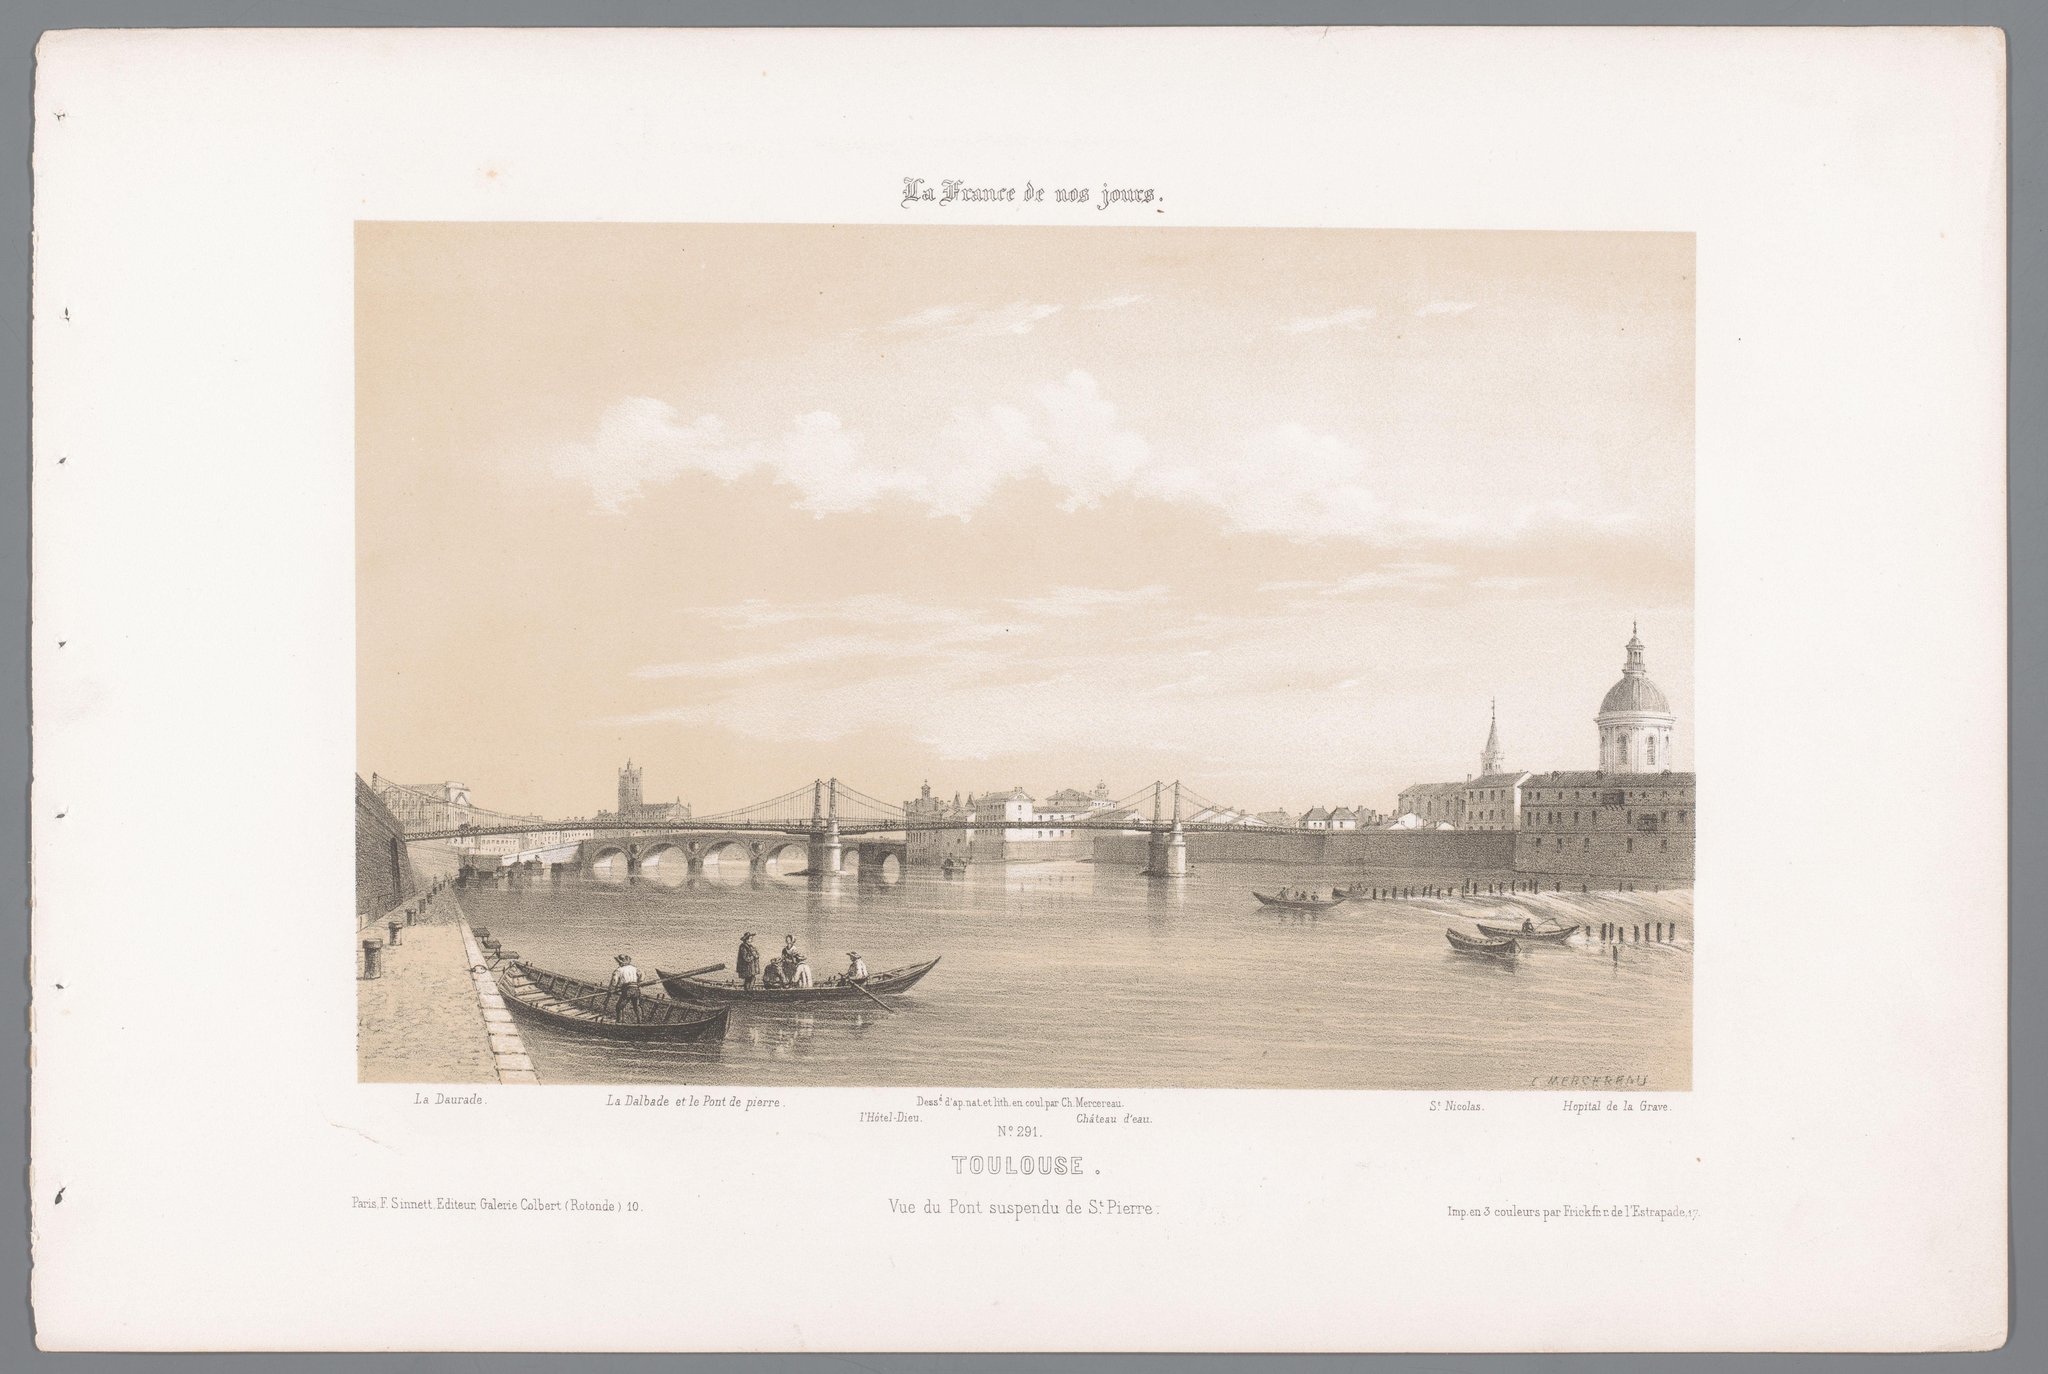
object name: print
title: Hedendaags Frankrijk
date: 1856-1874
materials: paper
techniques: tone lithography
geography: paris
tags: city-view, and landscape with man-made constructions, river, rowing-boat, canoe, etc., bridge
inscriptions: collector's mark: Lugt 2228